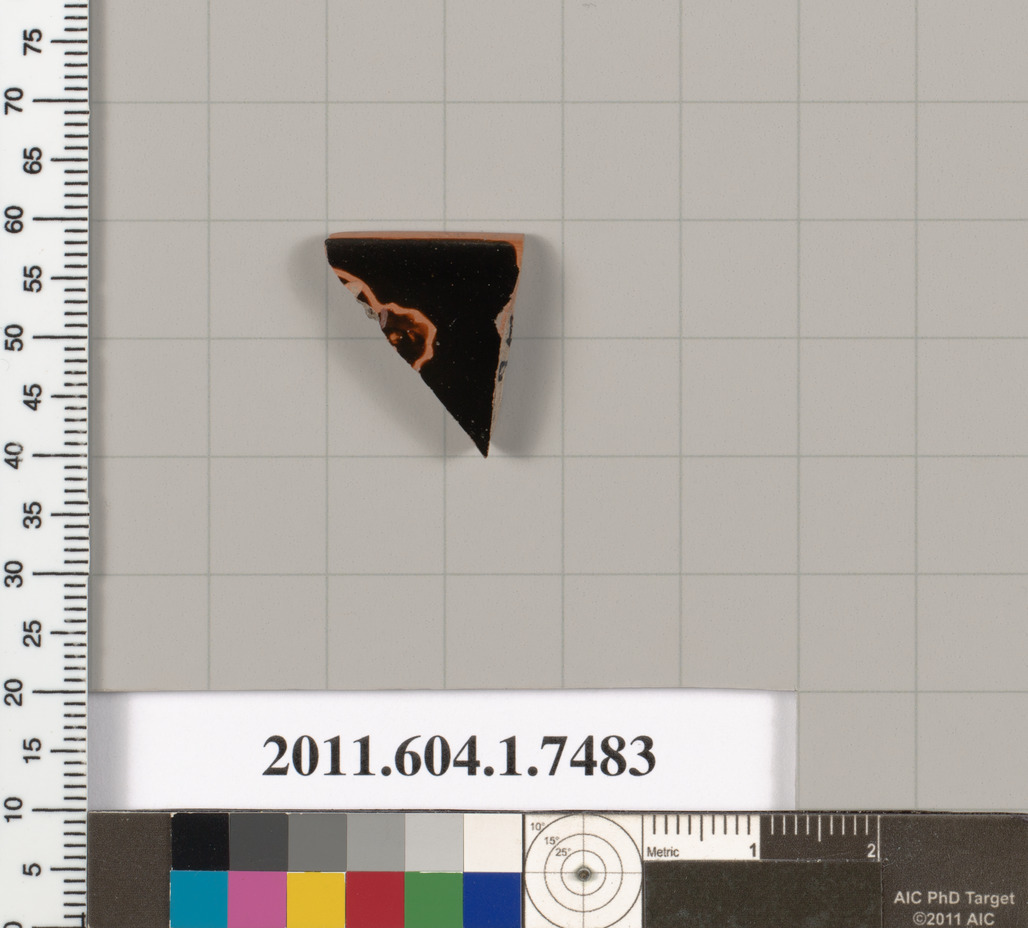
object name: kylix fragment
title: Terracotta rim fragment of a kylix (drinking cup)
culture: greek, attic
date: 460-450 BCE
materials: terracotta